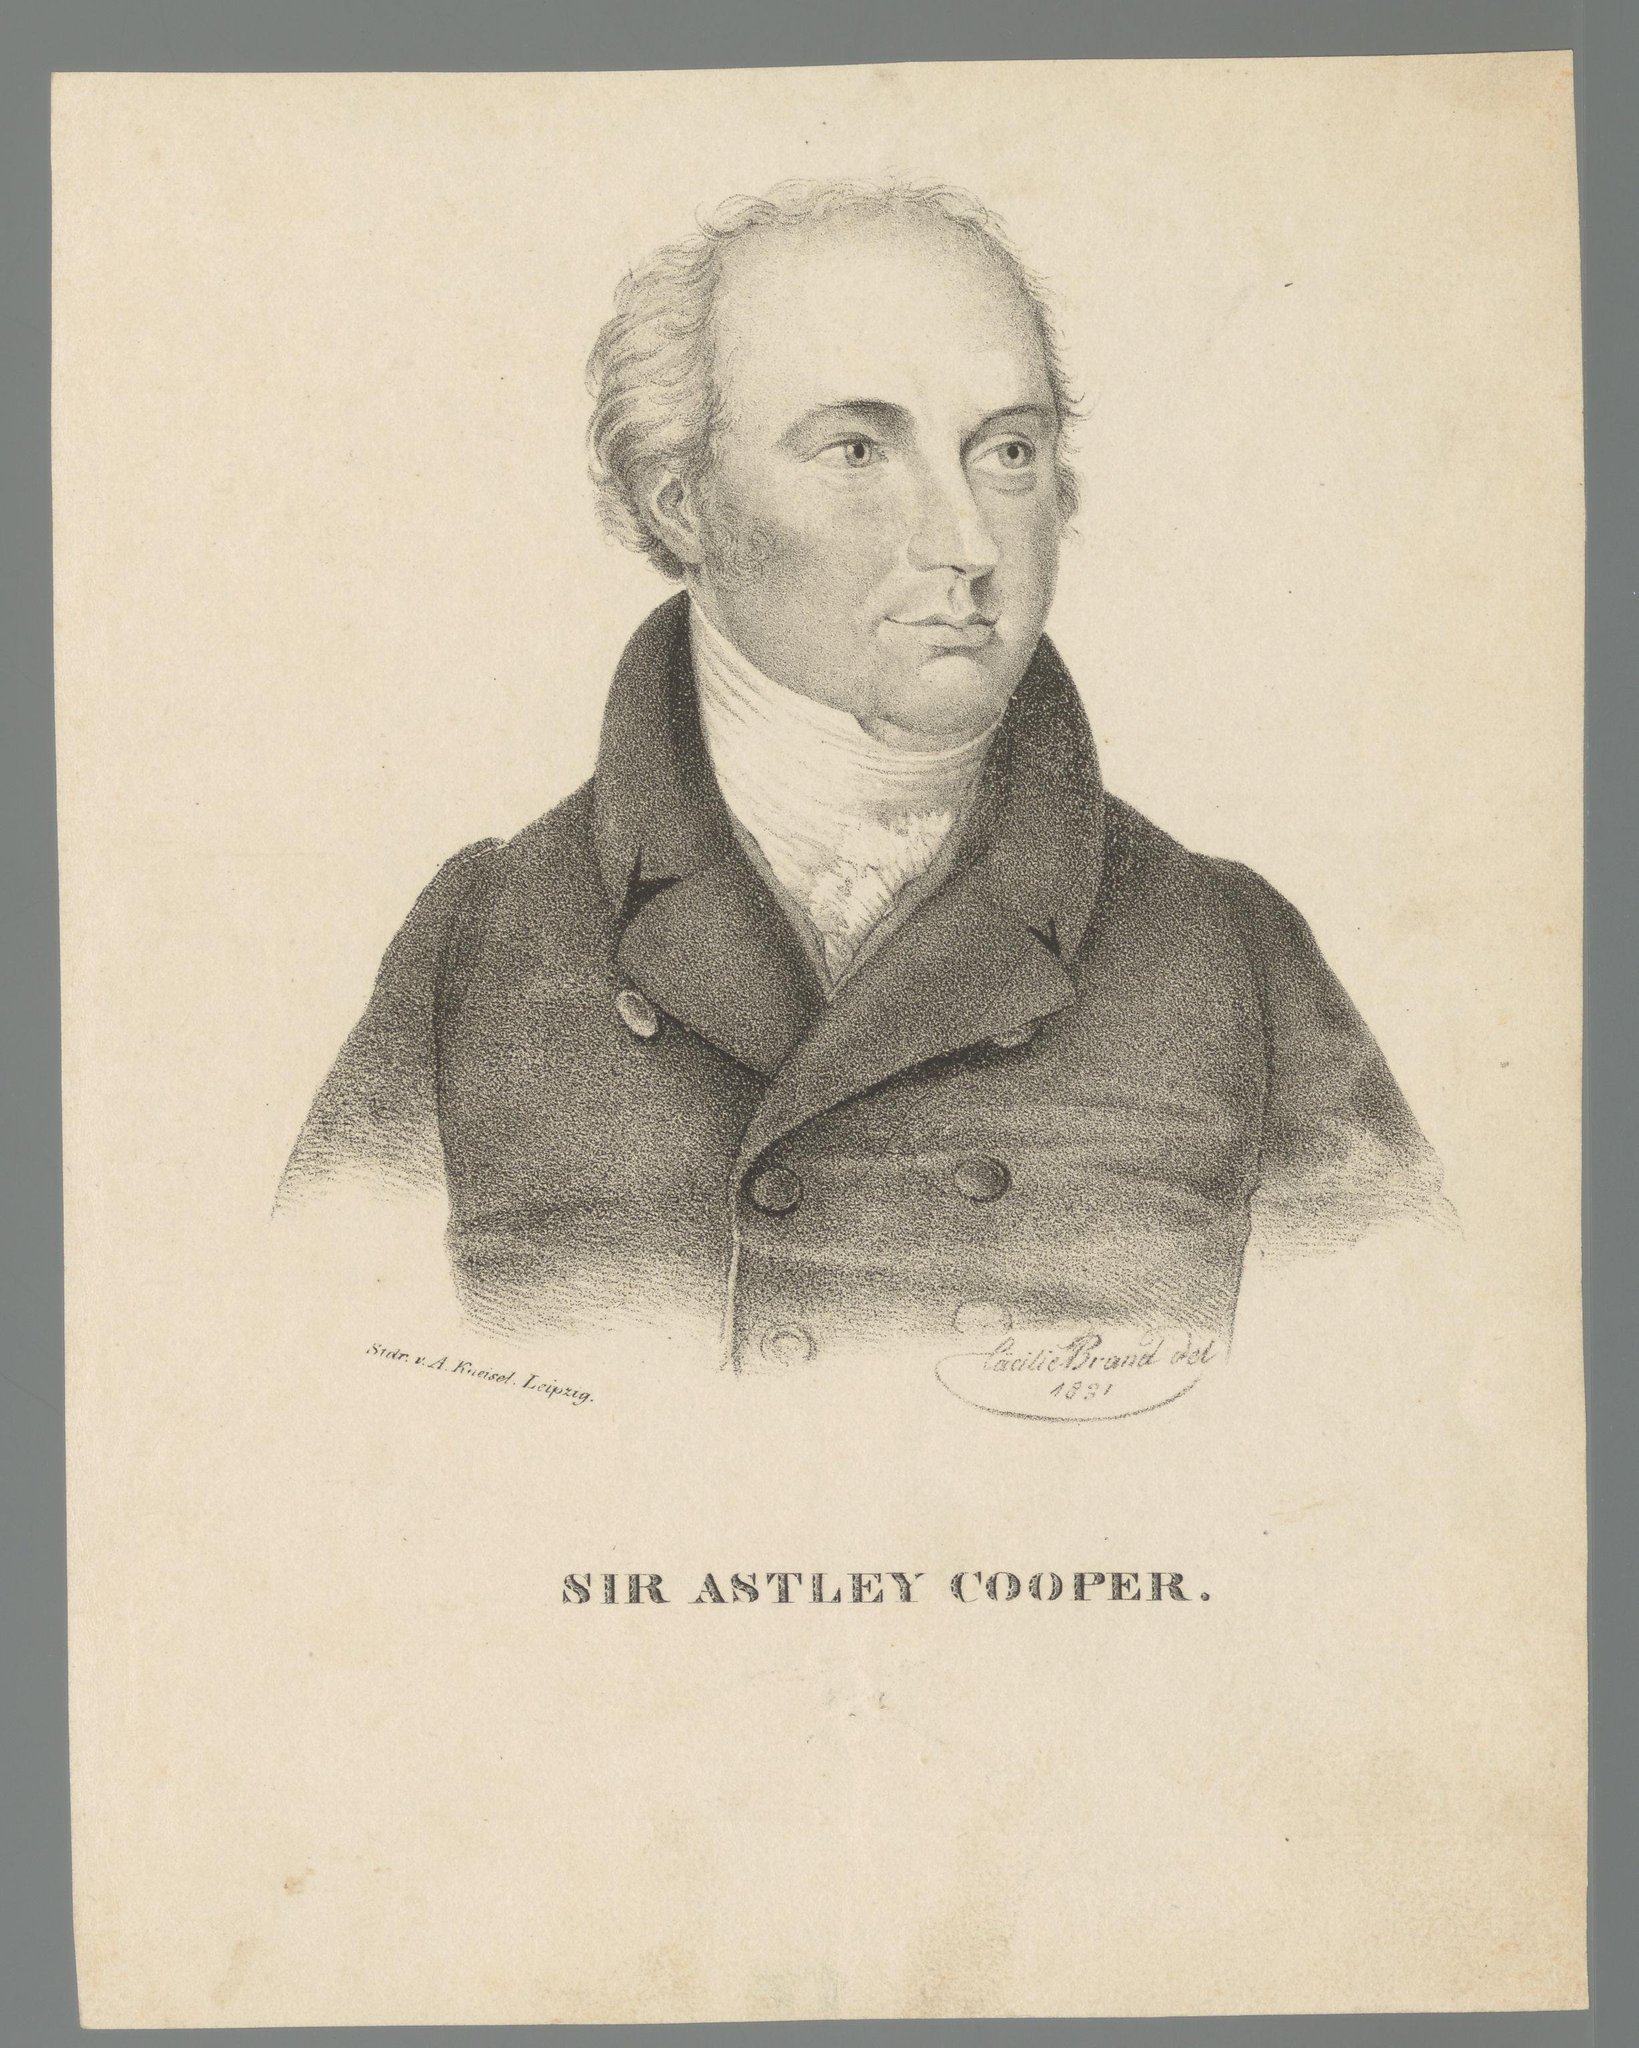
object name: print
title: Portret van Astley Paston Cooper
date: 1831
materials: paper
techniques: lithograph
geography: leipzig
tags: adult man, historical persons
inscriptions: collector's mark: Lugt 2228